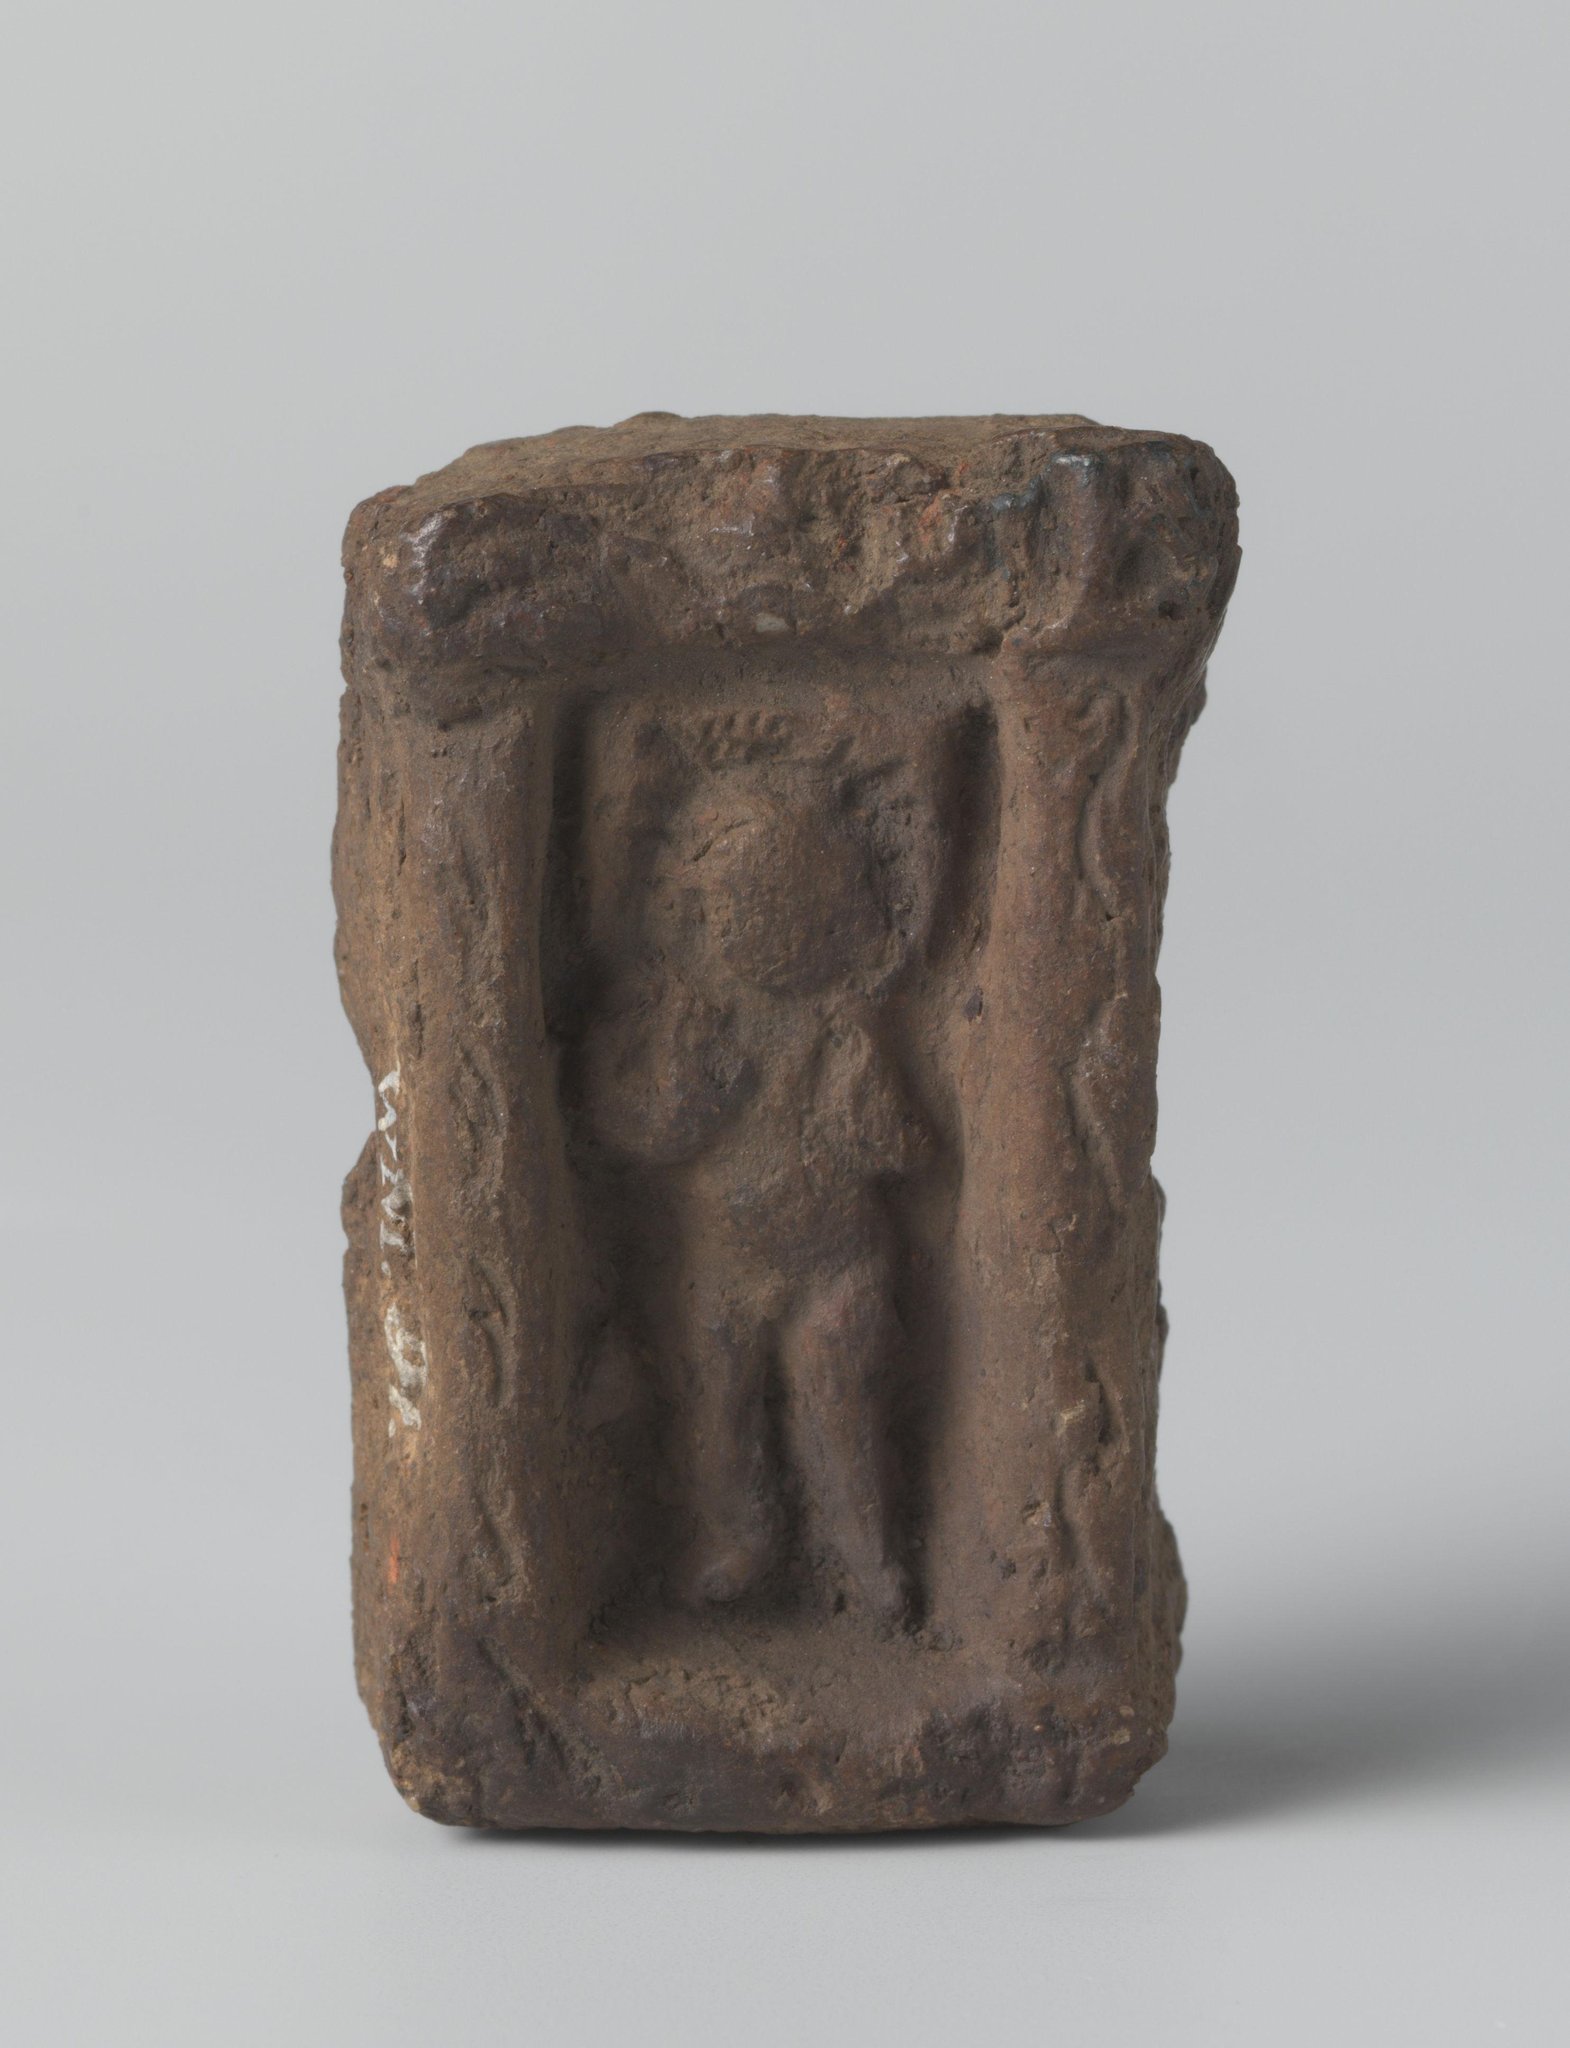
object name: sculpture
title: Crib with Christ Child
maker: Anonymous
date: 1475-1525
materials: clay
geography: northern netherlands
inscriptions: inscription, on the left side, in white paint: ‘WM.91.’